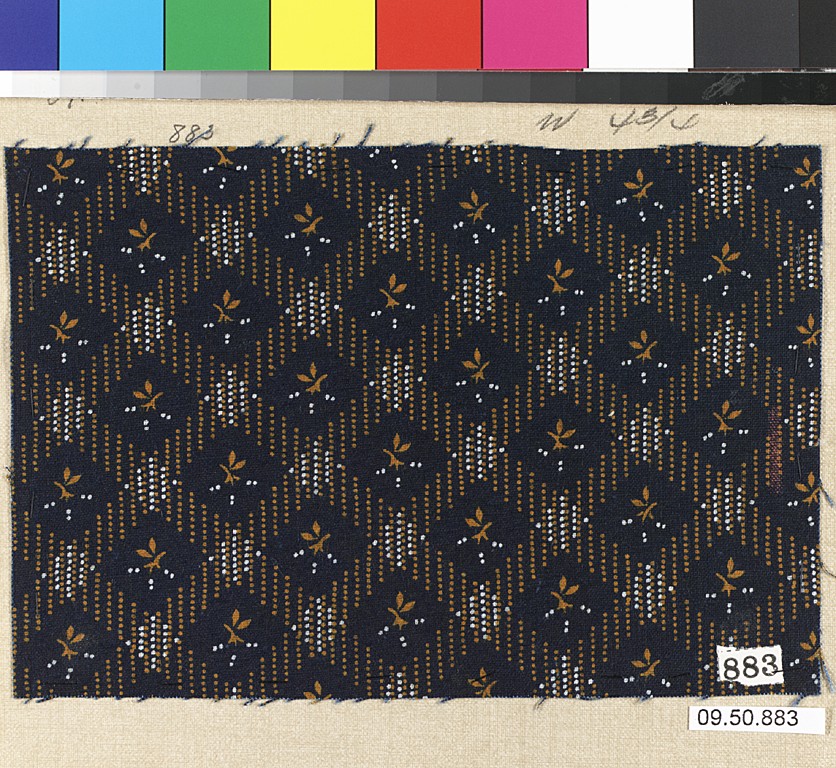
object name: piece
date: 1801-1900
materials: cotton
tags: leaves